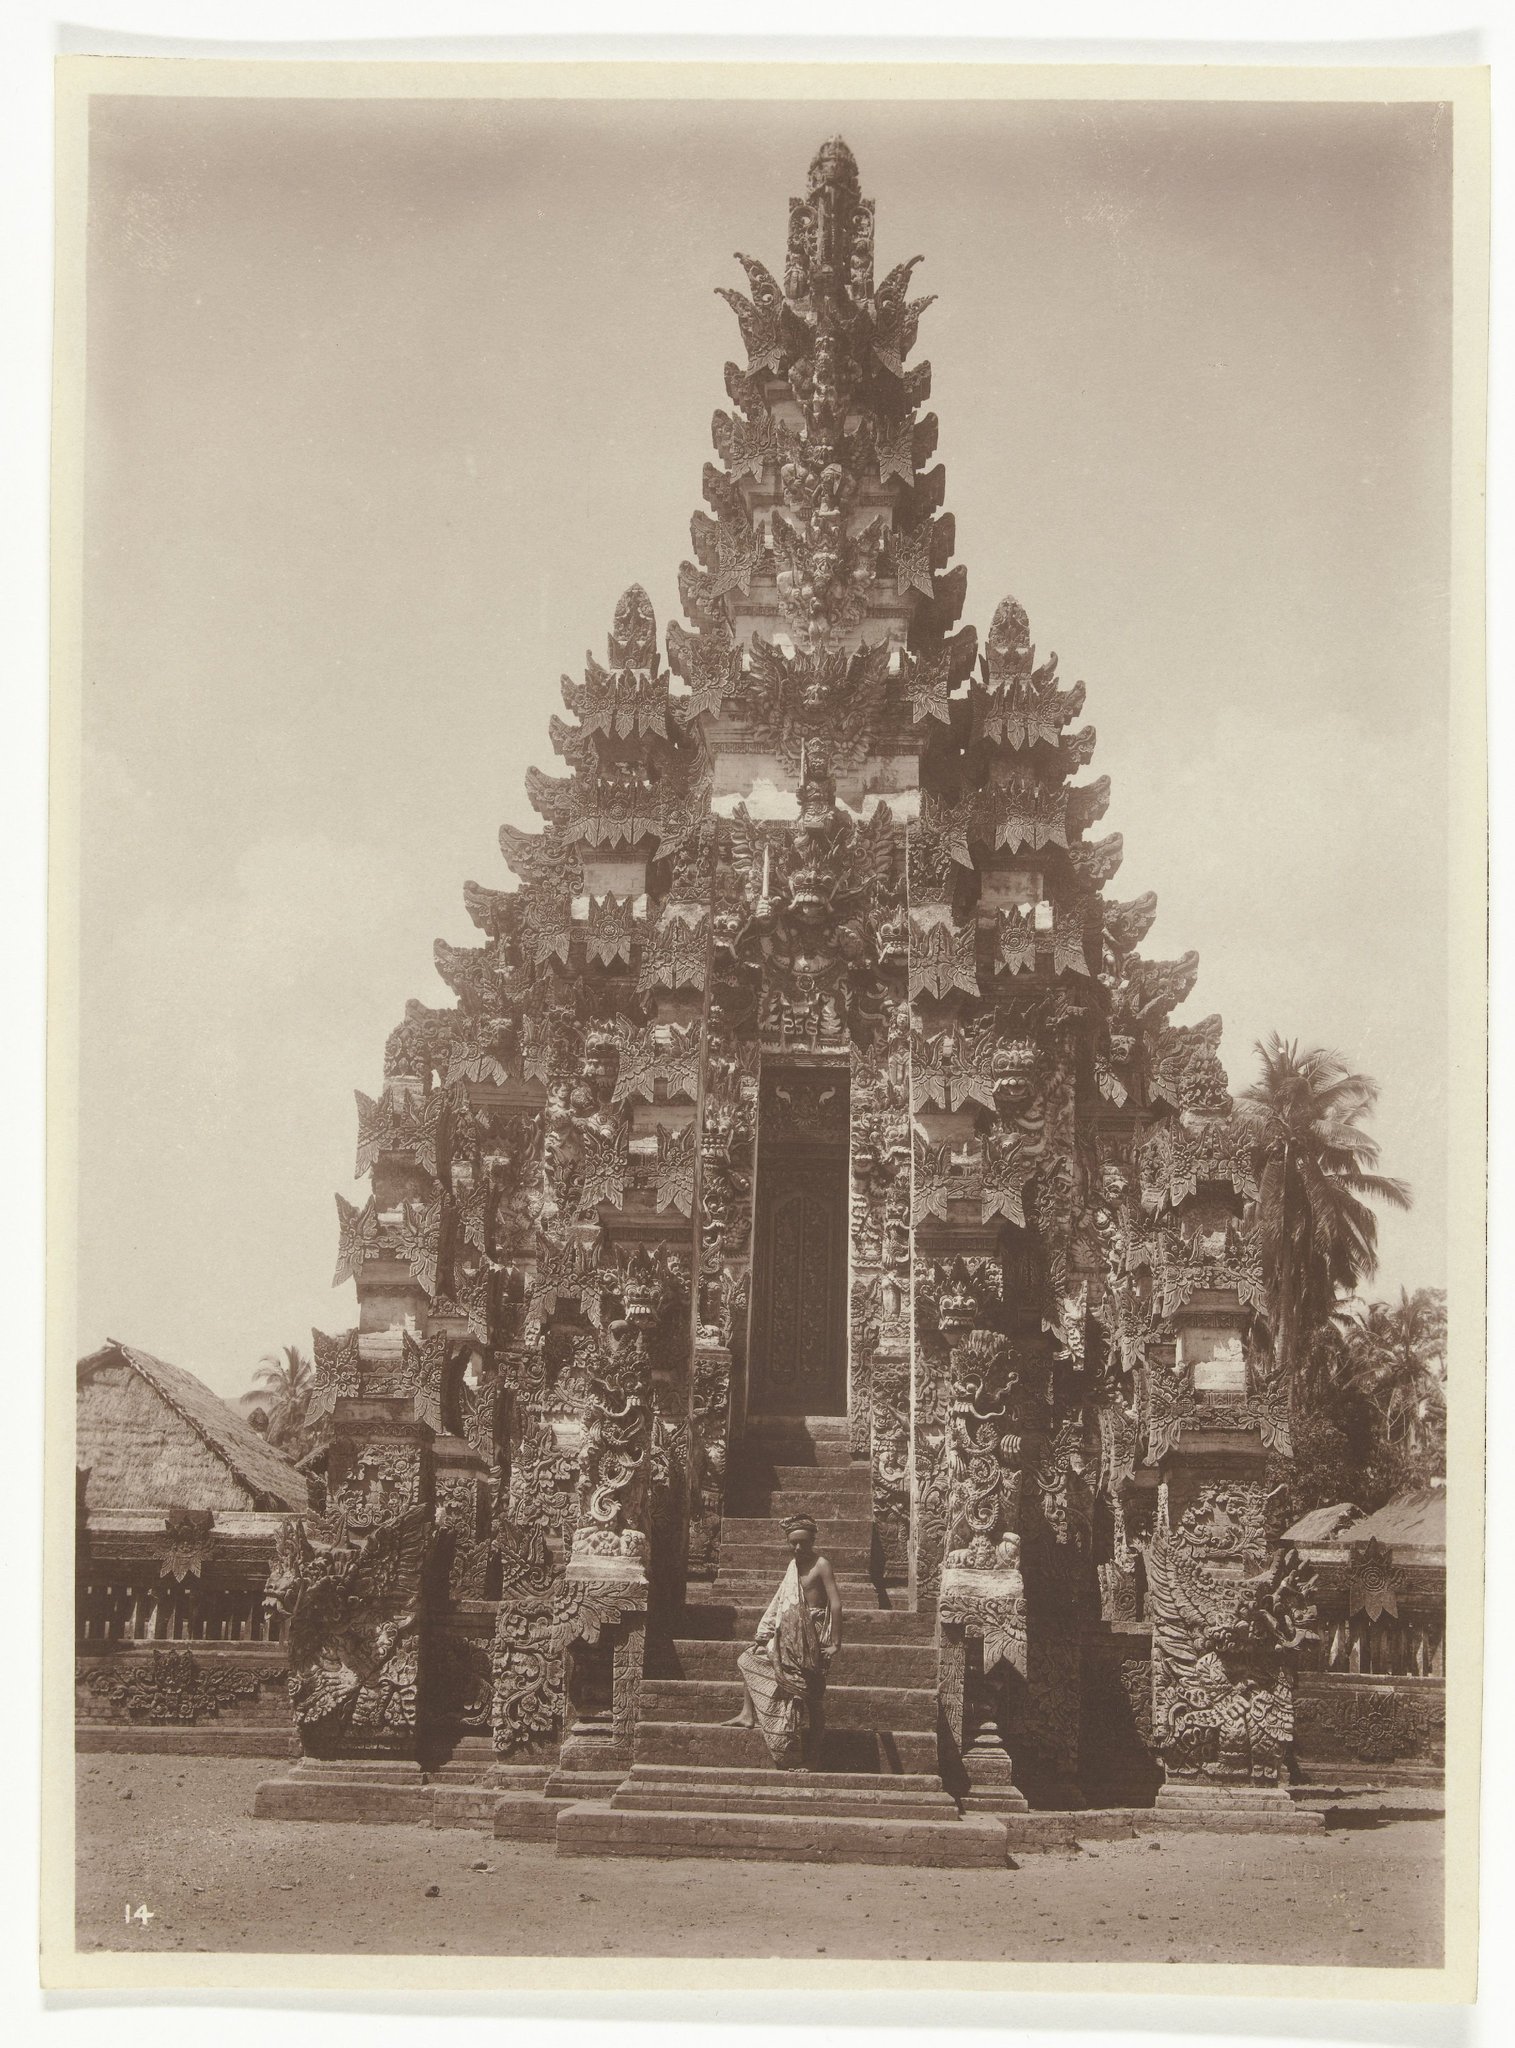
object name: photograph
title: Tempel in Bilabadjang, Bali, voormalig Nederlands-Indië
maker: onnes kurkdjian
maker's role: fotograaf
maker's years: 1851-1903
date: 1890-1910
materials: paper, photographic support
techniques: gelatin silver print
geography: surabaya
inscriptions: number: ‘14’, check stamp: ‘Kurkdjian / Sourabaia Java’, annotation: ‘Tempel te Bilabadjang. Bali’, stamp: ‘Foto Kurkdjian, Soerabaia (...)’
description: Een Javaanse jongeman poseert bij een rijk geornamenteerde tempel.